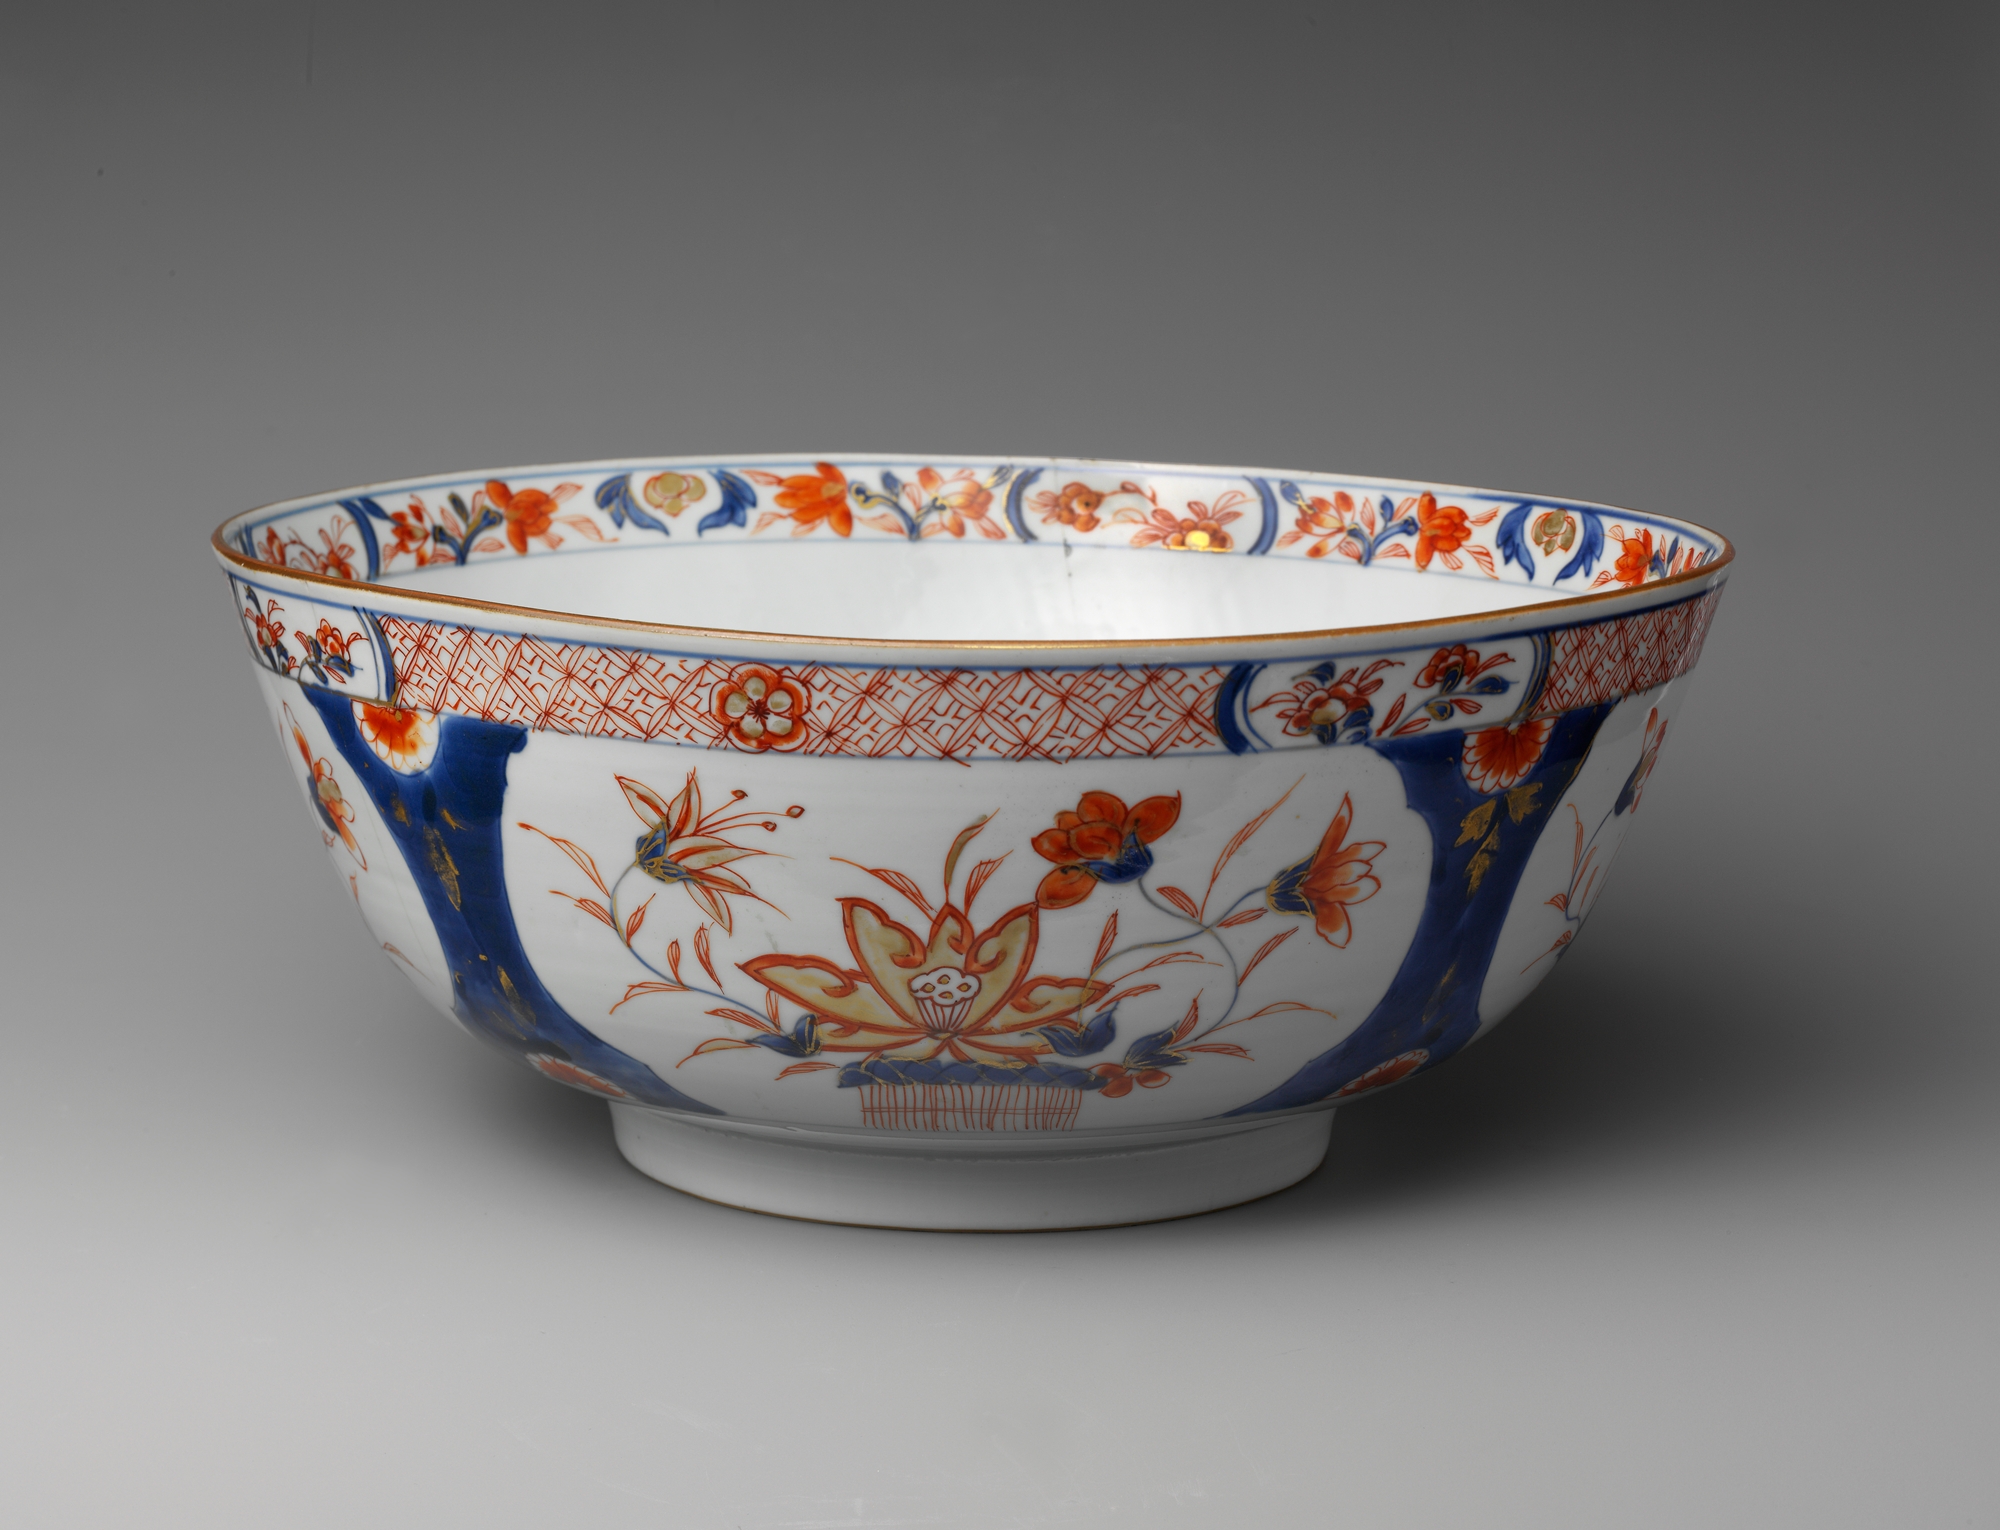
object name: bowl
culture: chinese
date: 1736-1795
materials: porcelain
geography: china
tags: flowers